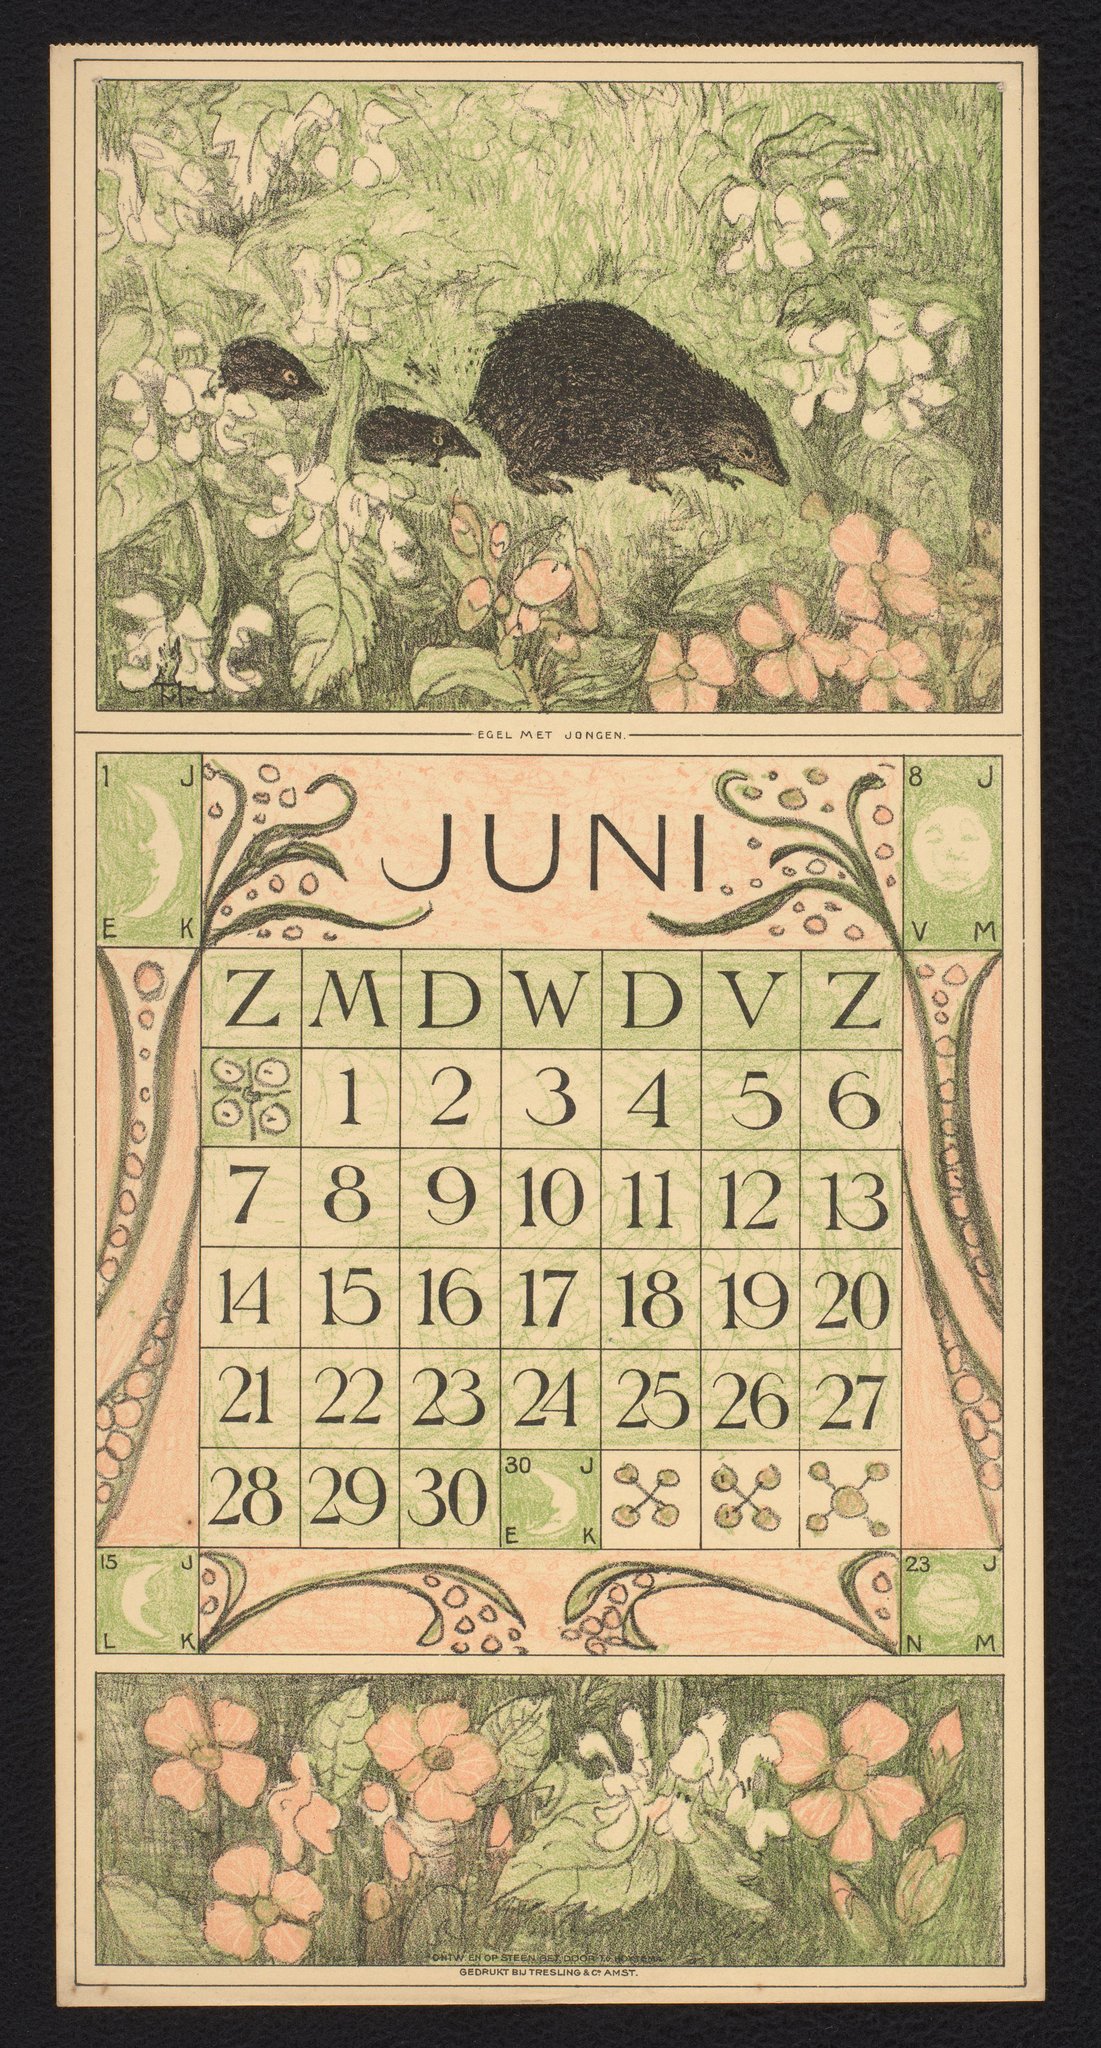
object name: print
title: Kalenderblad voor juni 1914 met een egel en twee jongen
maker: theo van hoytema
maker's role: draughtsman, painter, print maker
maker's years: 1863-1917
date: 1913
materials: paper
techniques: lithograph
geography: amsterdam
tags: calendar, almanac, other mammals: hedgehog